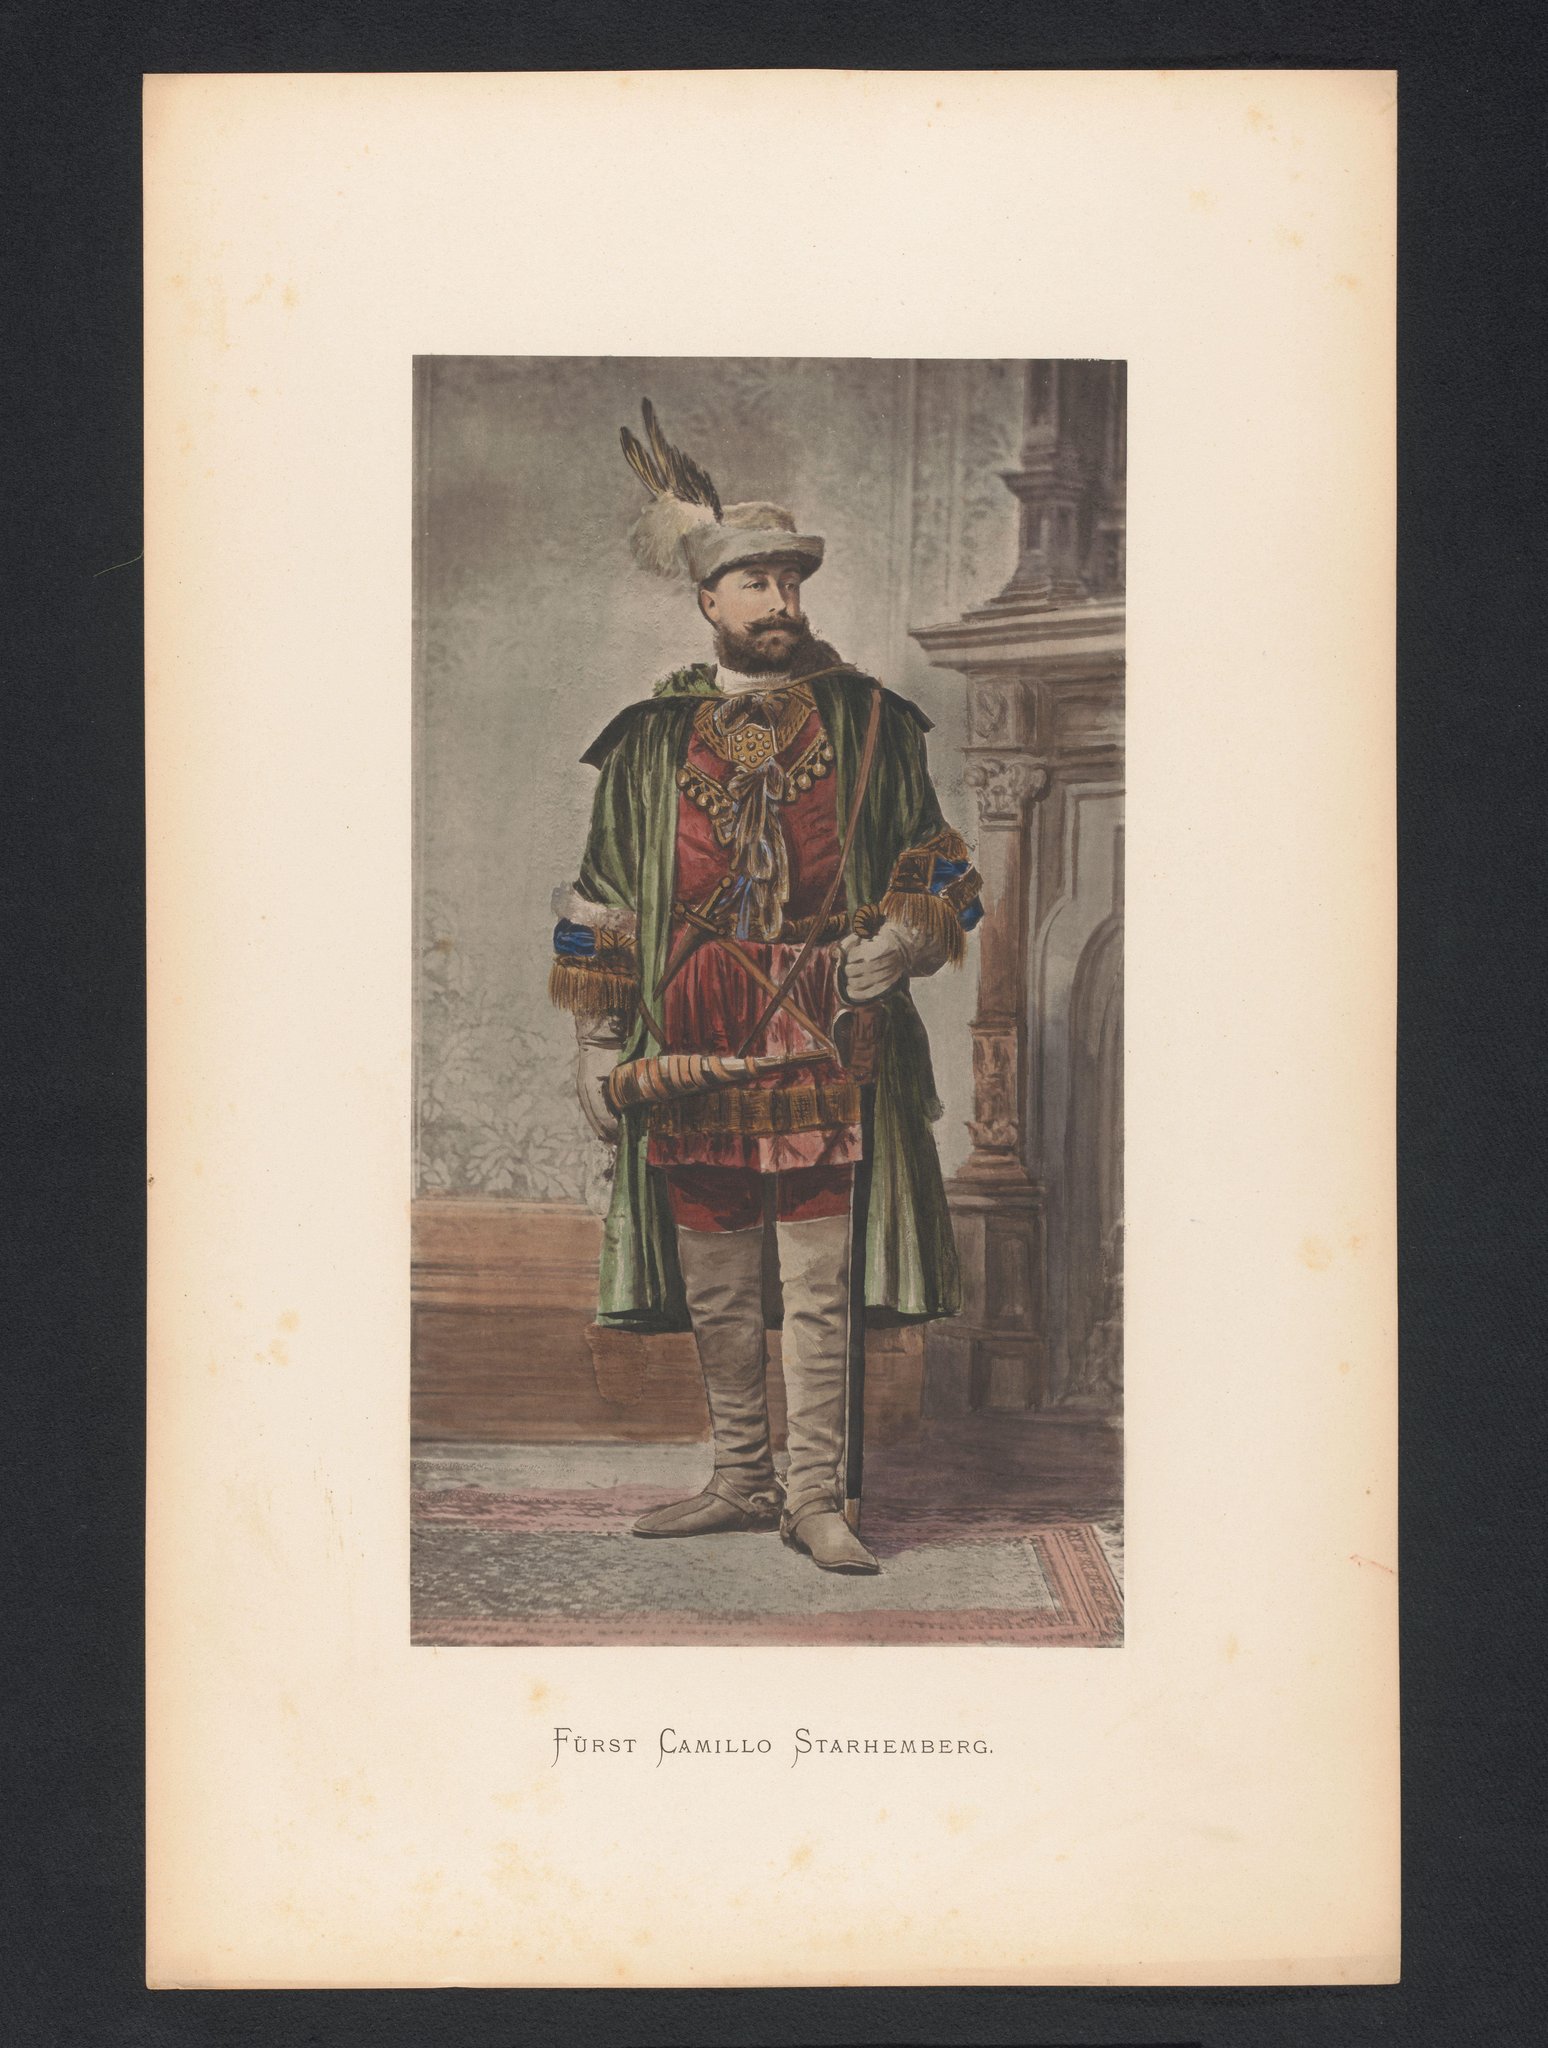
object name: photomechanical print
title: Portret van Camillo Heinirch von Starhemberg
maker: Anonymous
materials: paper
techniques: photograph, hand coloring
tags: vienna, aristocracy; 'aristocratia' (ripa), historical persons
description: Deze prent maakt deel uit van een omslag met 86 prenten op 78 bladen en 11 tekstbladen.